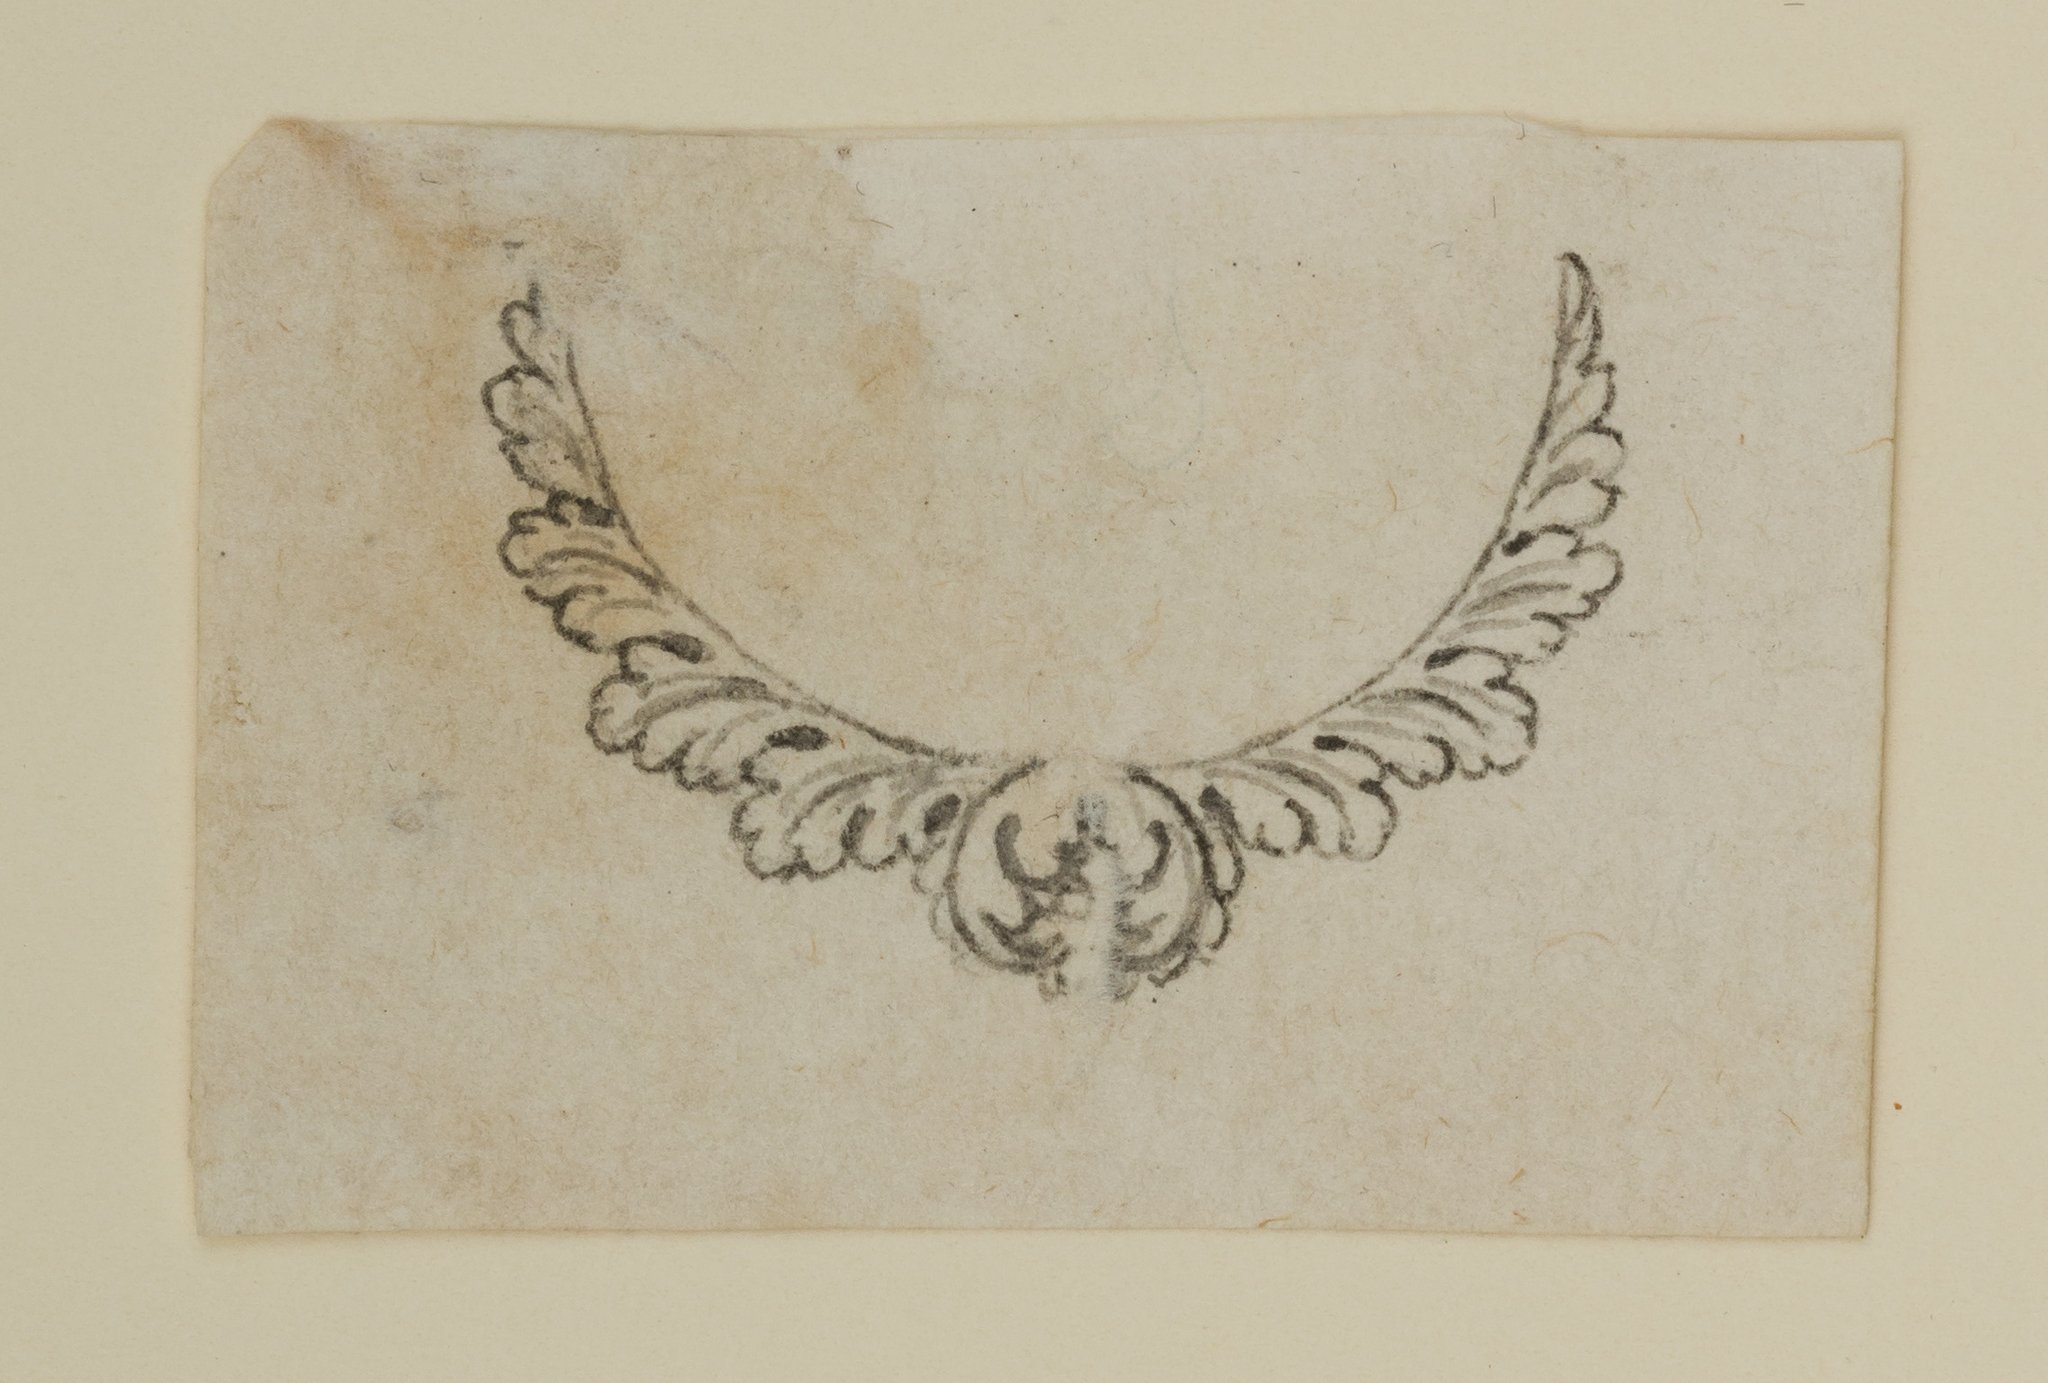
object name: drawing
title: Design for the Decoration of Firearms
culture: french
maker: nicolas noël boutet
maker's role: designer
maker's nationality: french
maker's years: 1761-1833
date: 1797-1805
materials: ink, paper, pencil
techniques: wash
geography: france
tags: ornament